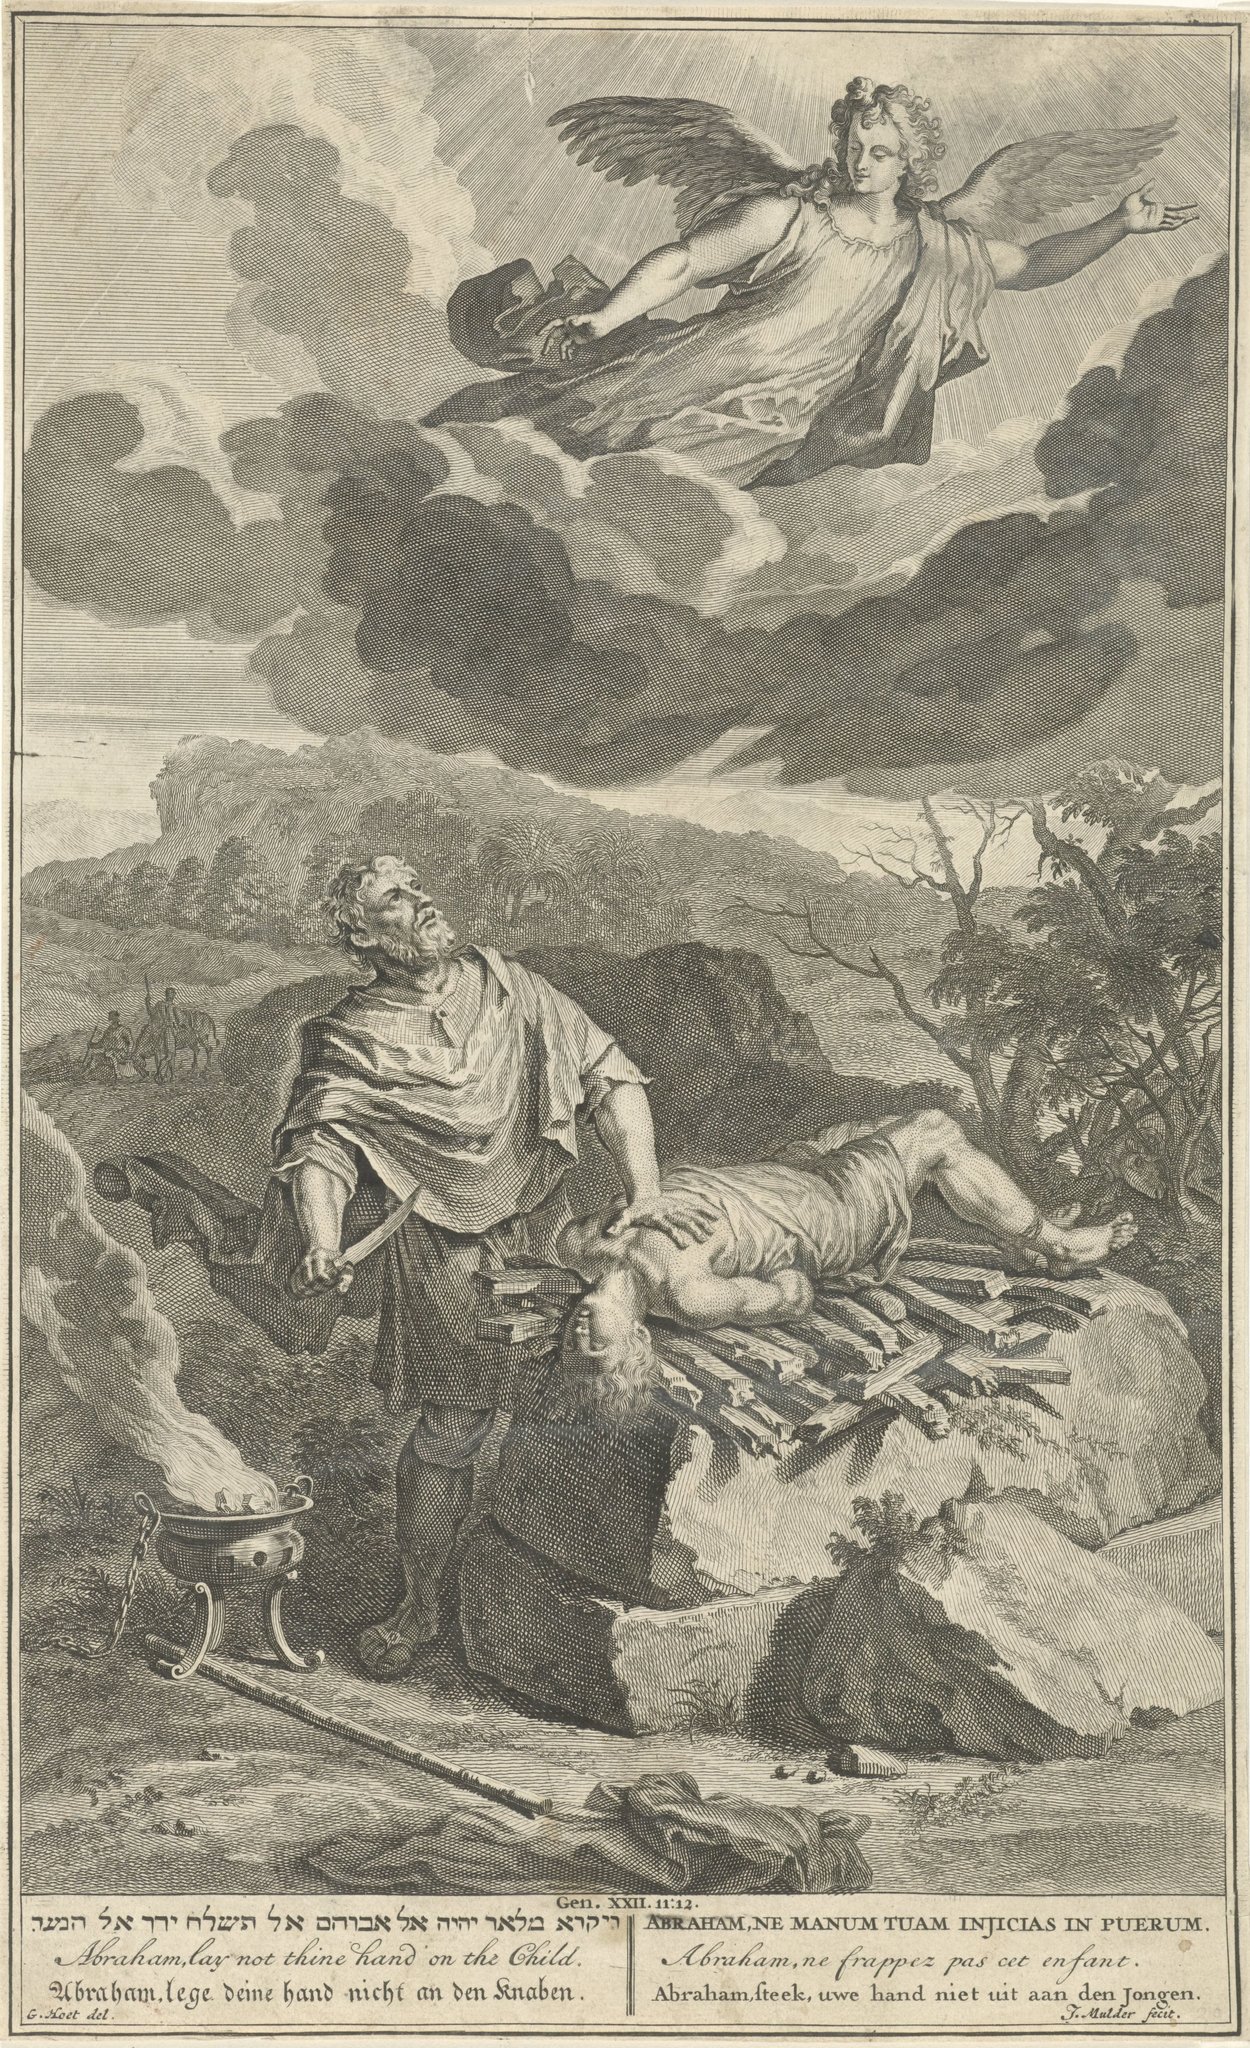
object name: book illustration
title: Offer van Isaak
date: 1720-1728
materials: paper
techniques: engraving, etching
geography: amsterdam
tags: the sacrifice of isaac (genesis 22)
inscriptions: collector's mark: Lugt 2228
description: Abraham, met een mes in de hand, staat op het punt zijn zoon Isaak te offeren, maar een engel weerhoudt hem daarvan. Rechts een ram in de struiken, die in Isaaks plaats zal worden geofferd. Links in het landschap de ezel en knechten, die Abraham had achtergelaten. Onderaan in de marge een verwijzing naar de Bijbeltekst en de titel in het Hebreeuws, Engels, Duits, Latijn, Frans en Nederlands.